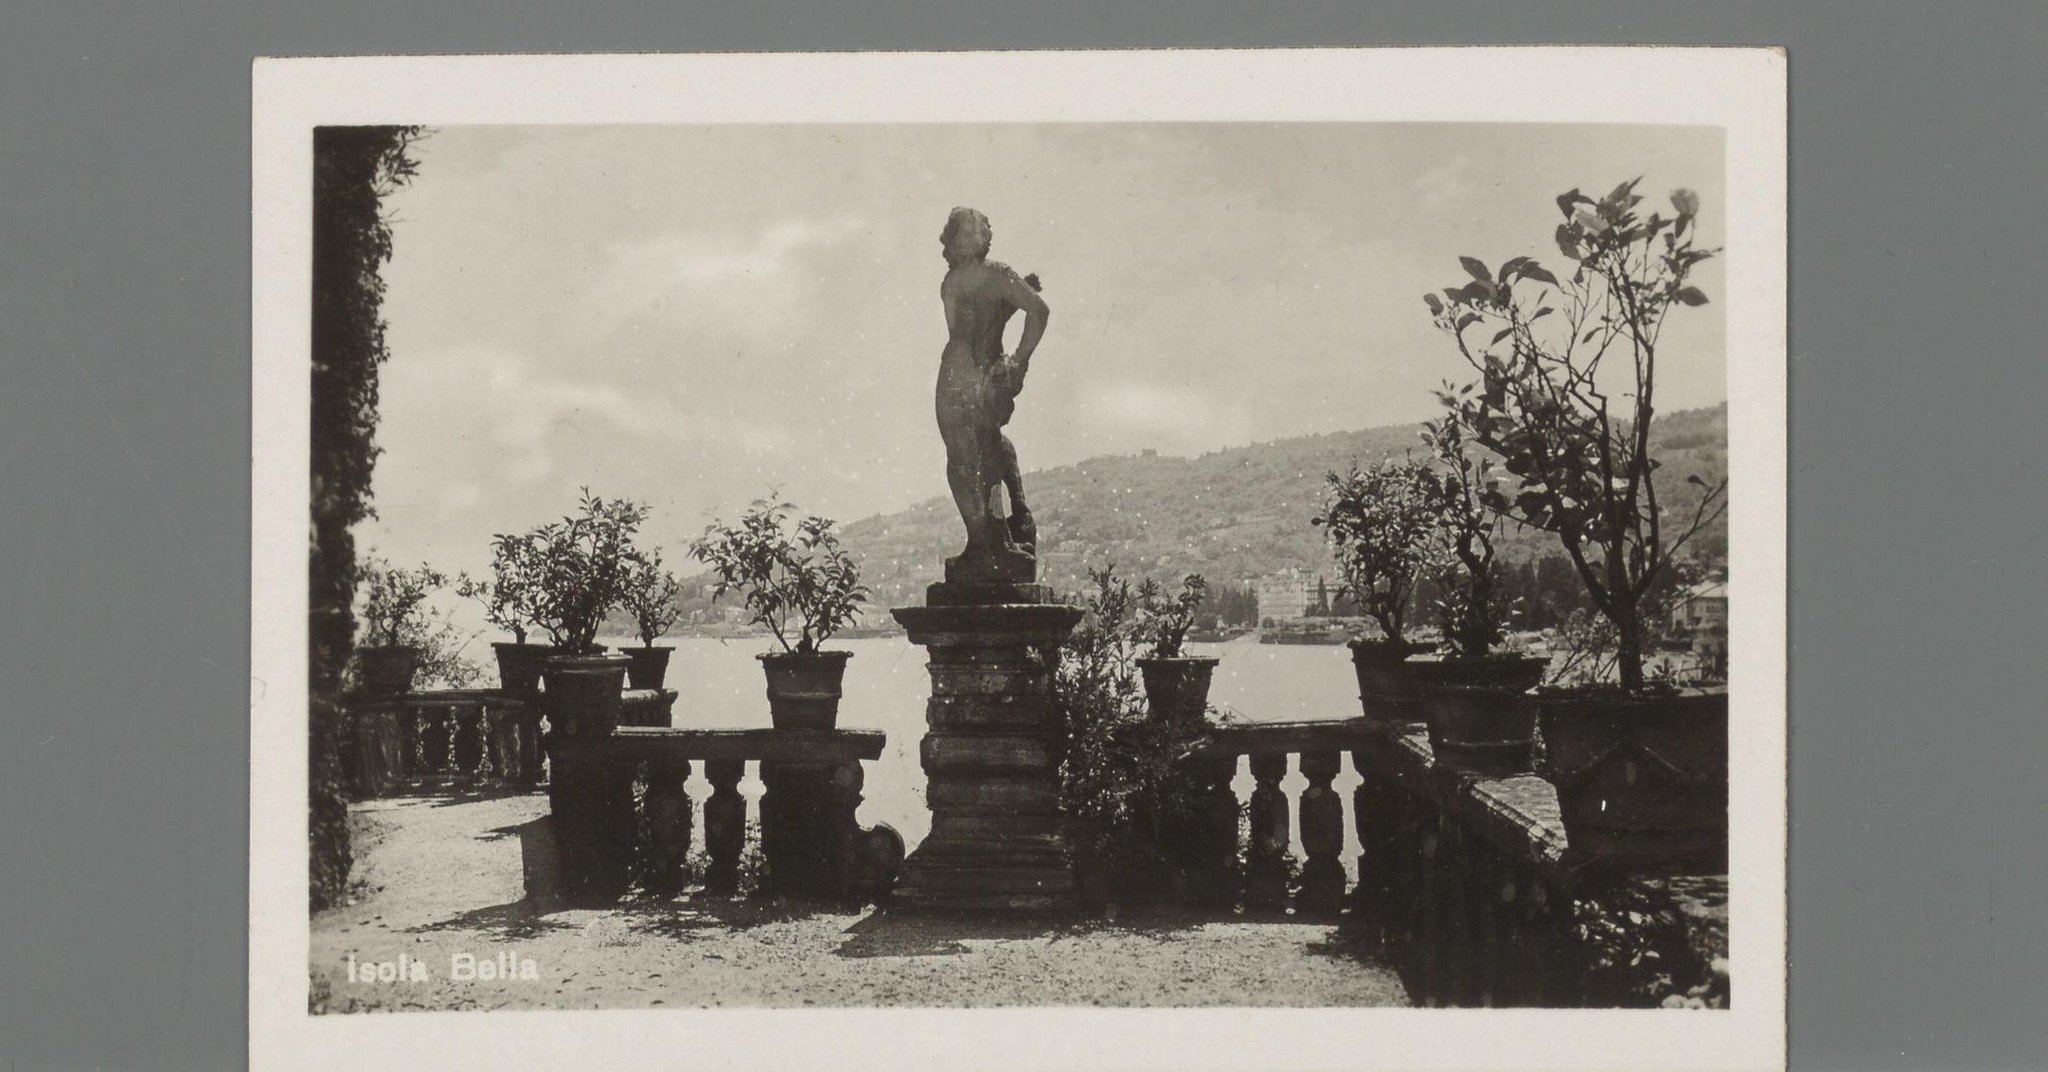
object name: photograph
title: Isola Bella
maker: Anonymous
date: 1904-1935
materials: photographic support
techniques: photography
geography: como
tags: lake, public gardens, park